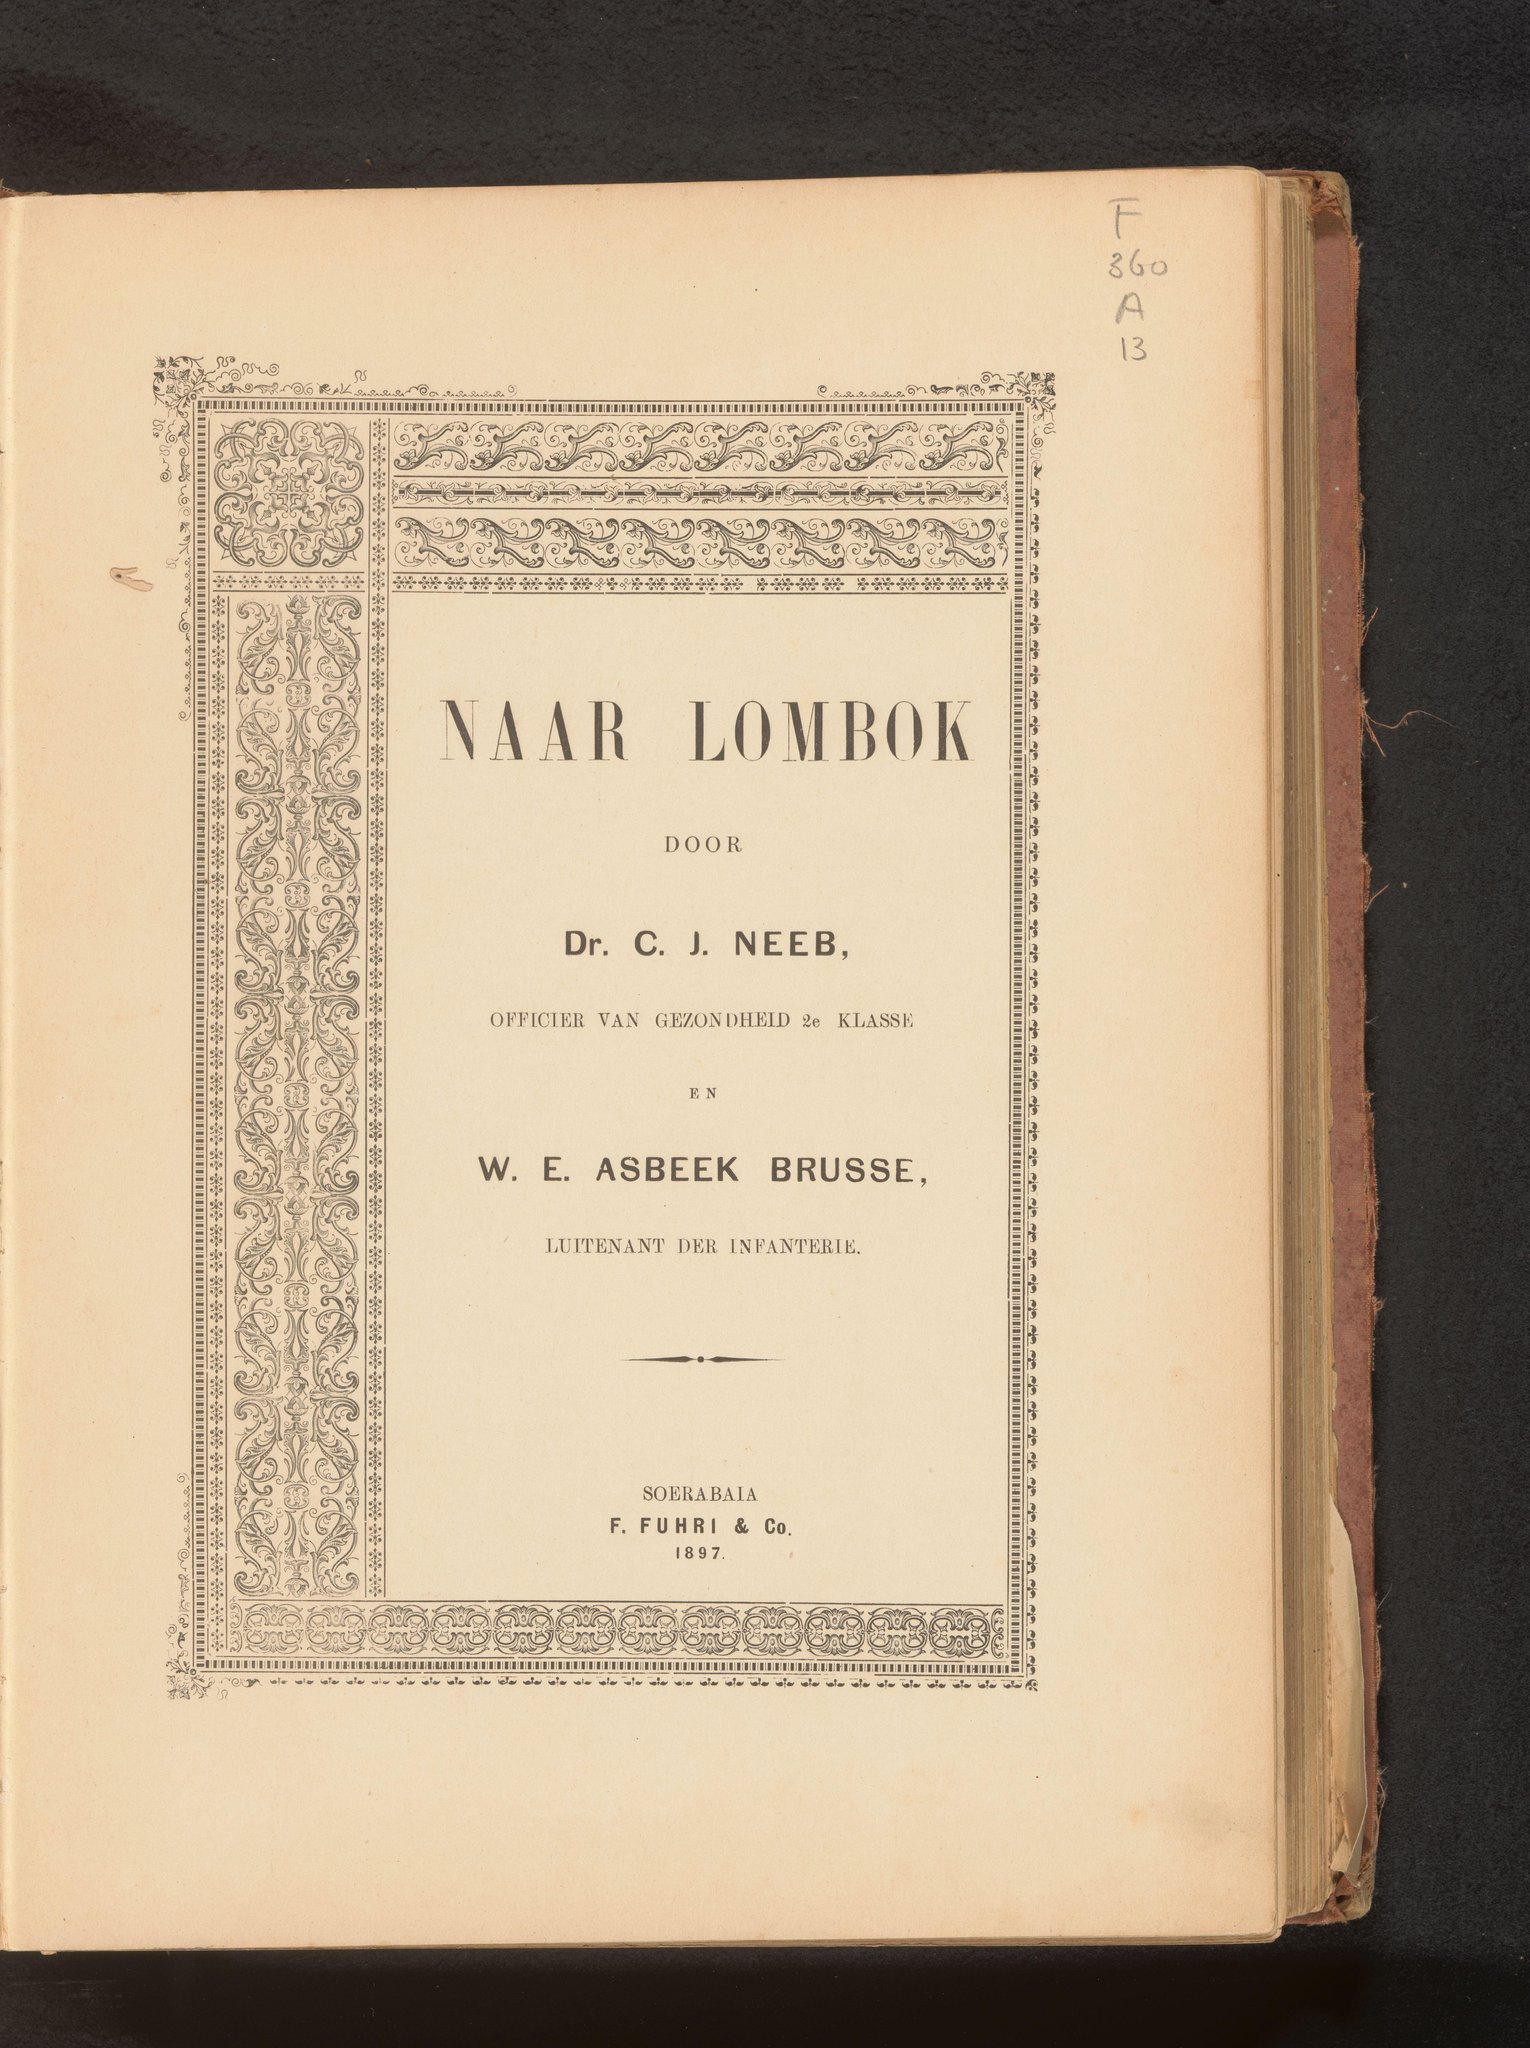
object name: book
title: Naar Lombok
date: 1897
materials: cardboard, paper, textile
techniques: photograph, printing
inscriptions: date: ‘DEC/ 1999’